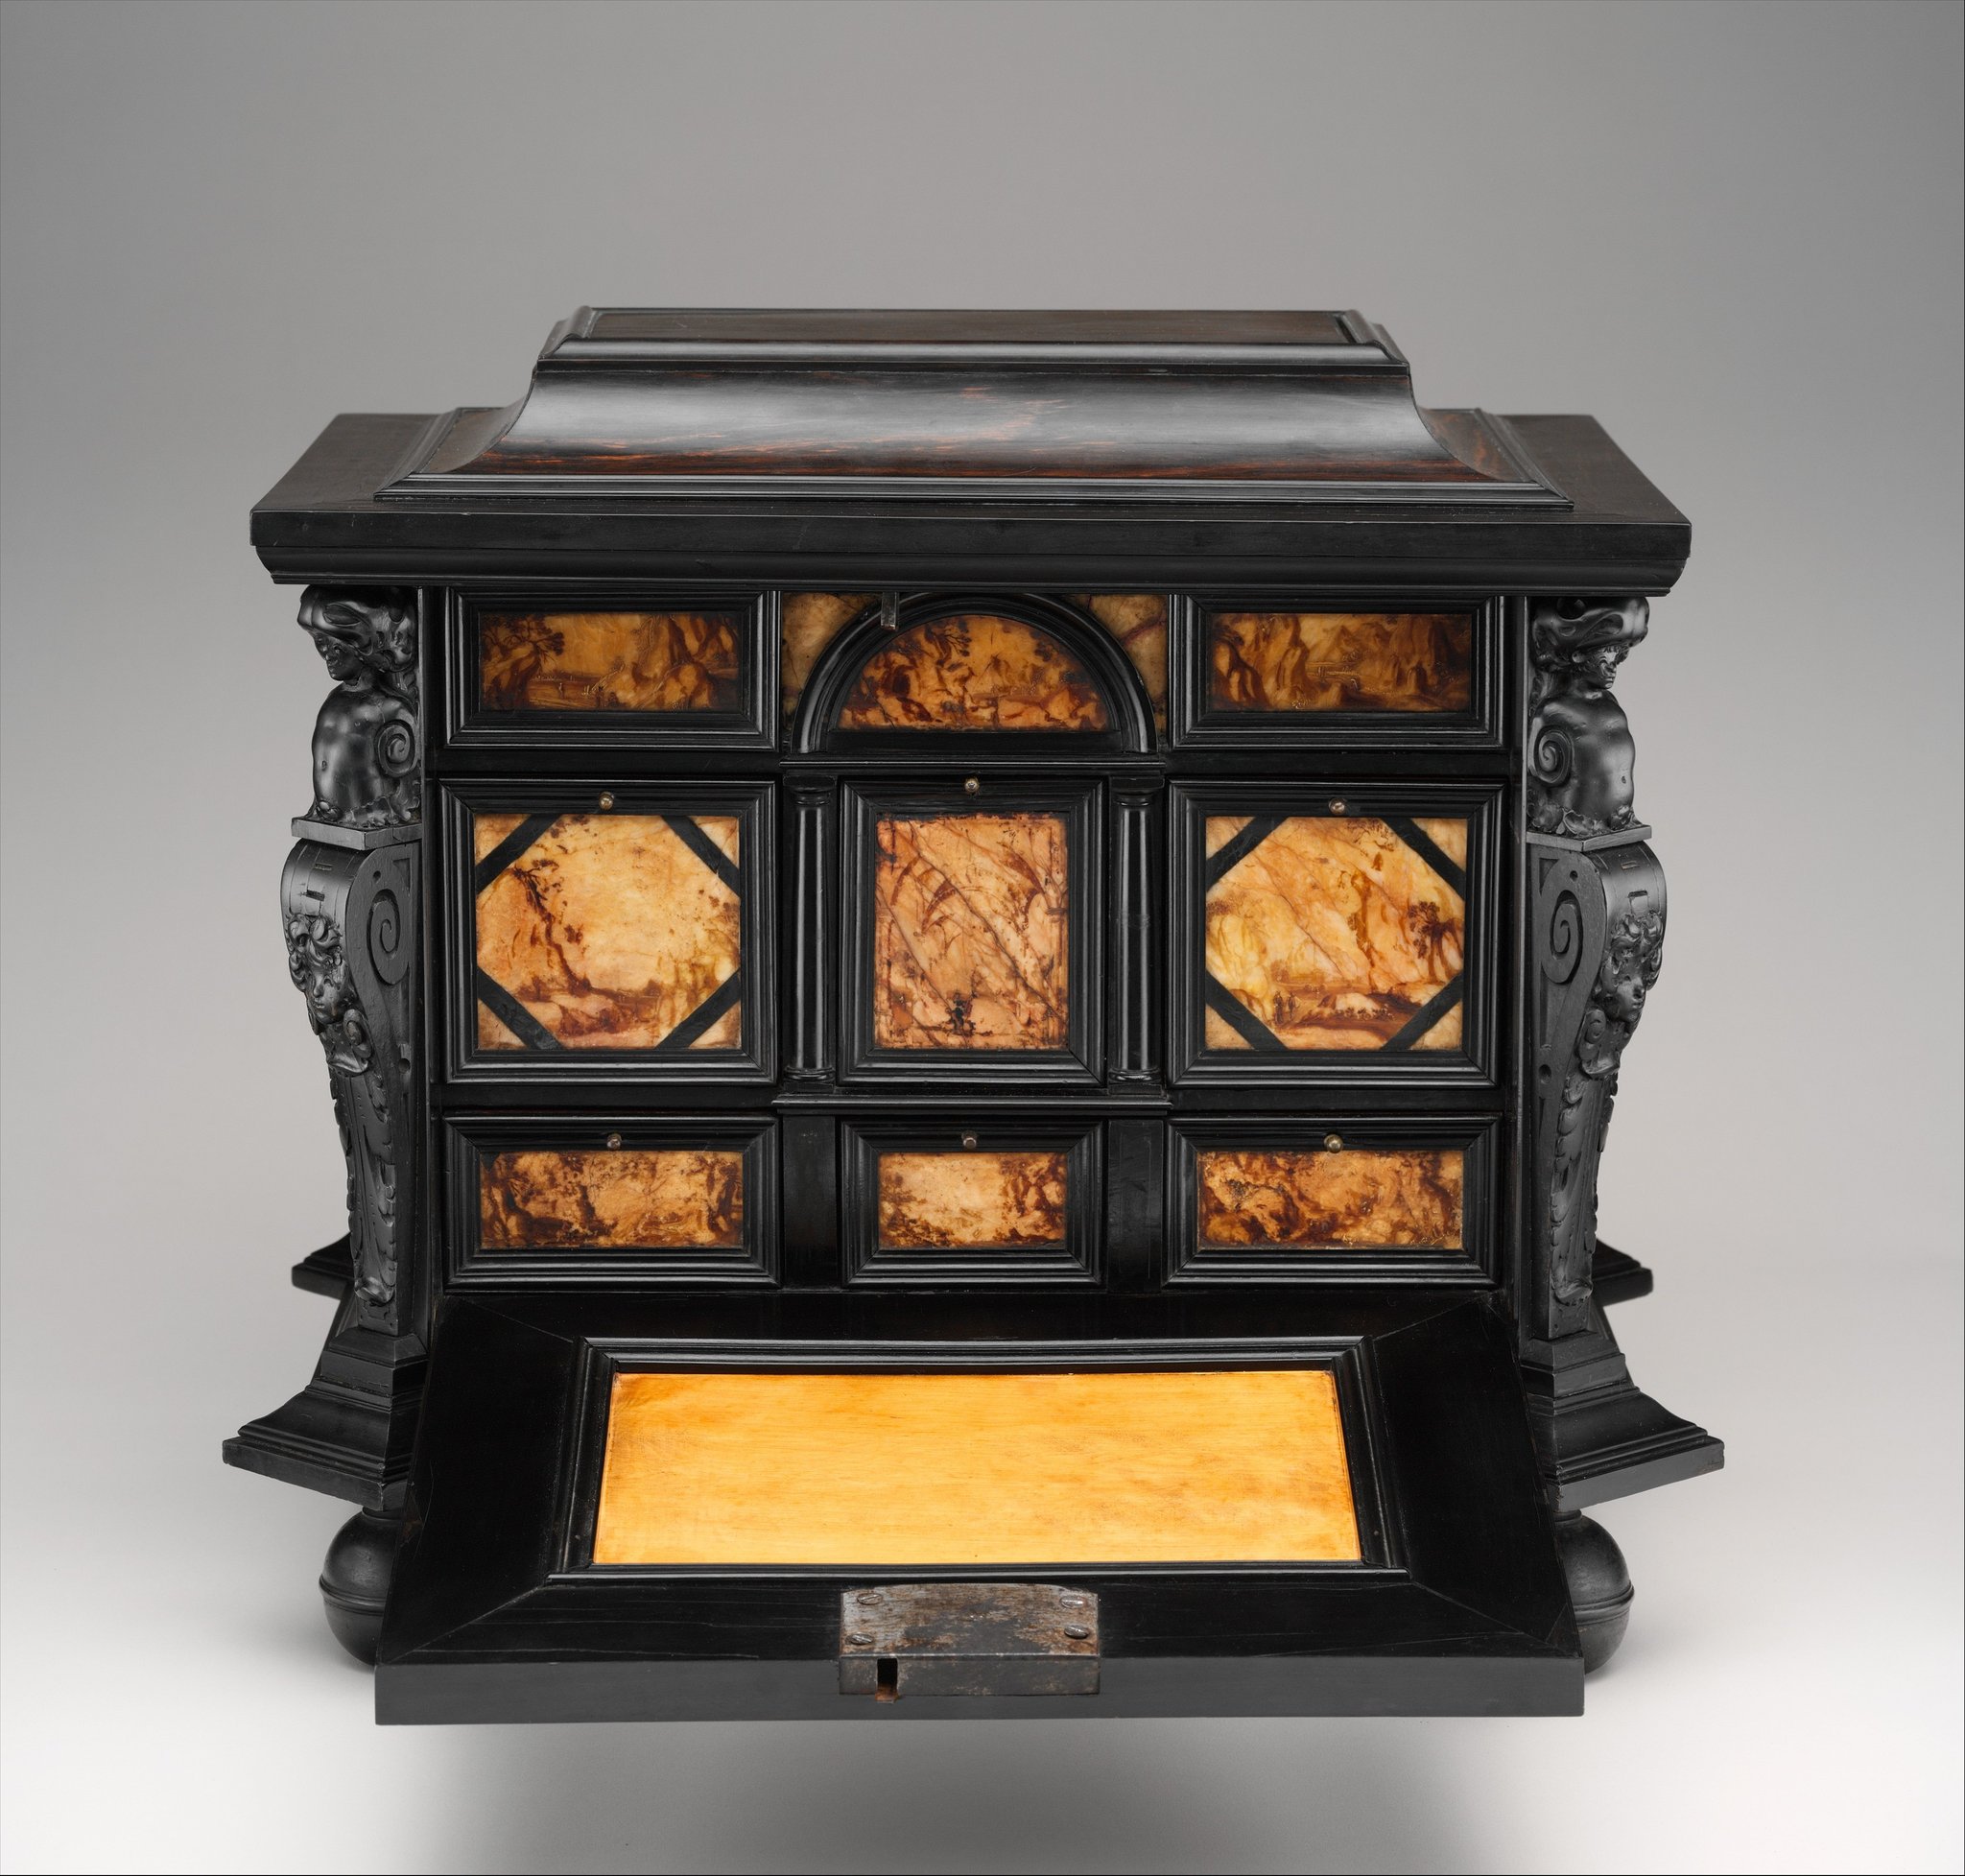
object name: coffer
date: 1634-1666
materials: alabaster, wood, glass, ivory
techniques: painting, veneering